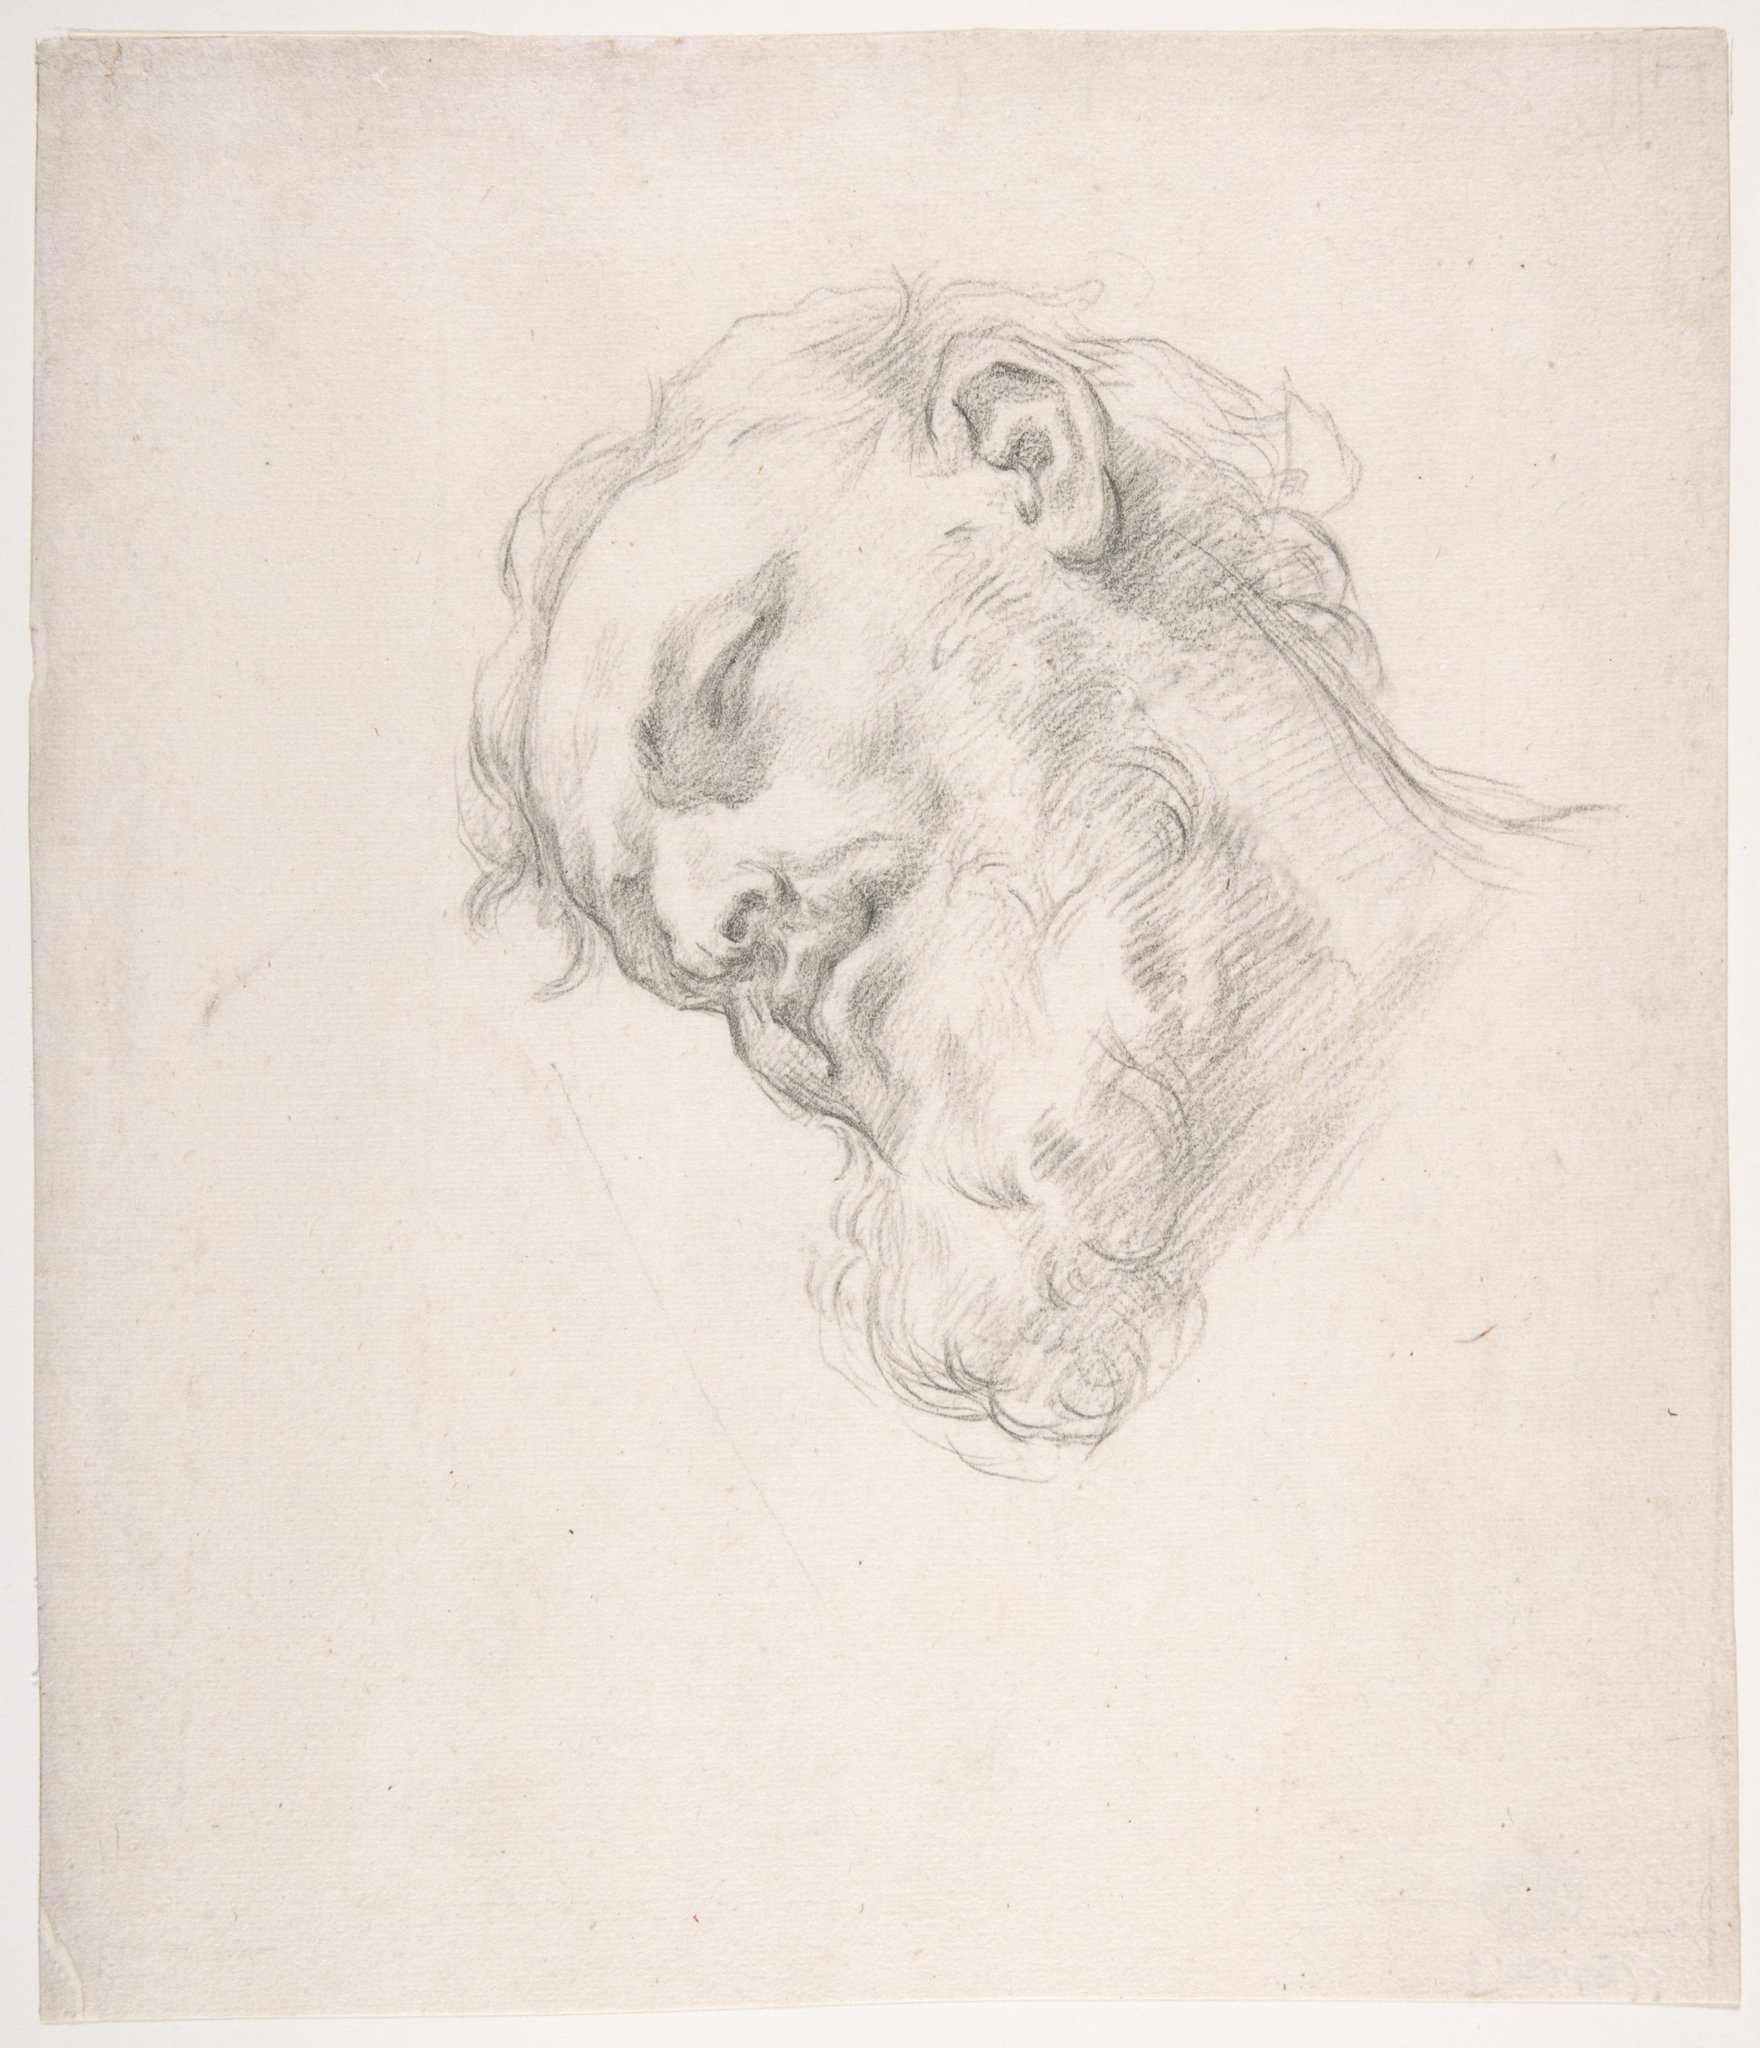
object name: drawing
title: Study for a Head of a Man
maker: carlo maratti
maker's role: artist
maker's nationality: italian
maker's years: 1625-1713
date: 1625-1713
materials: chalk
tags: heads,men